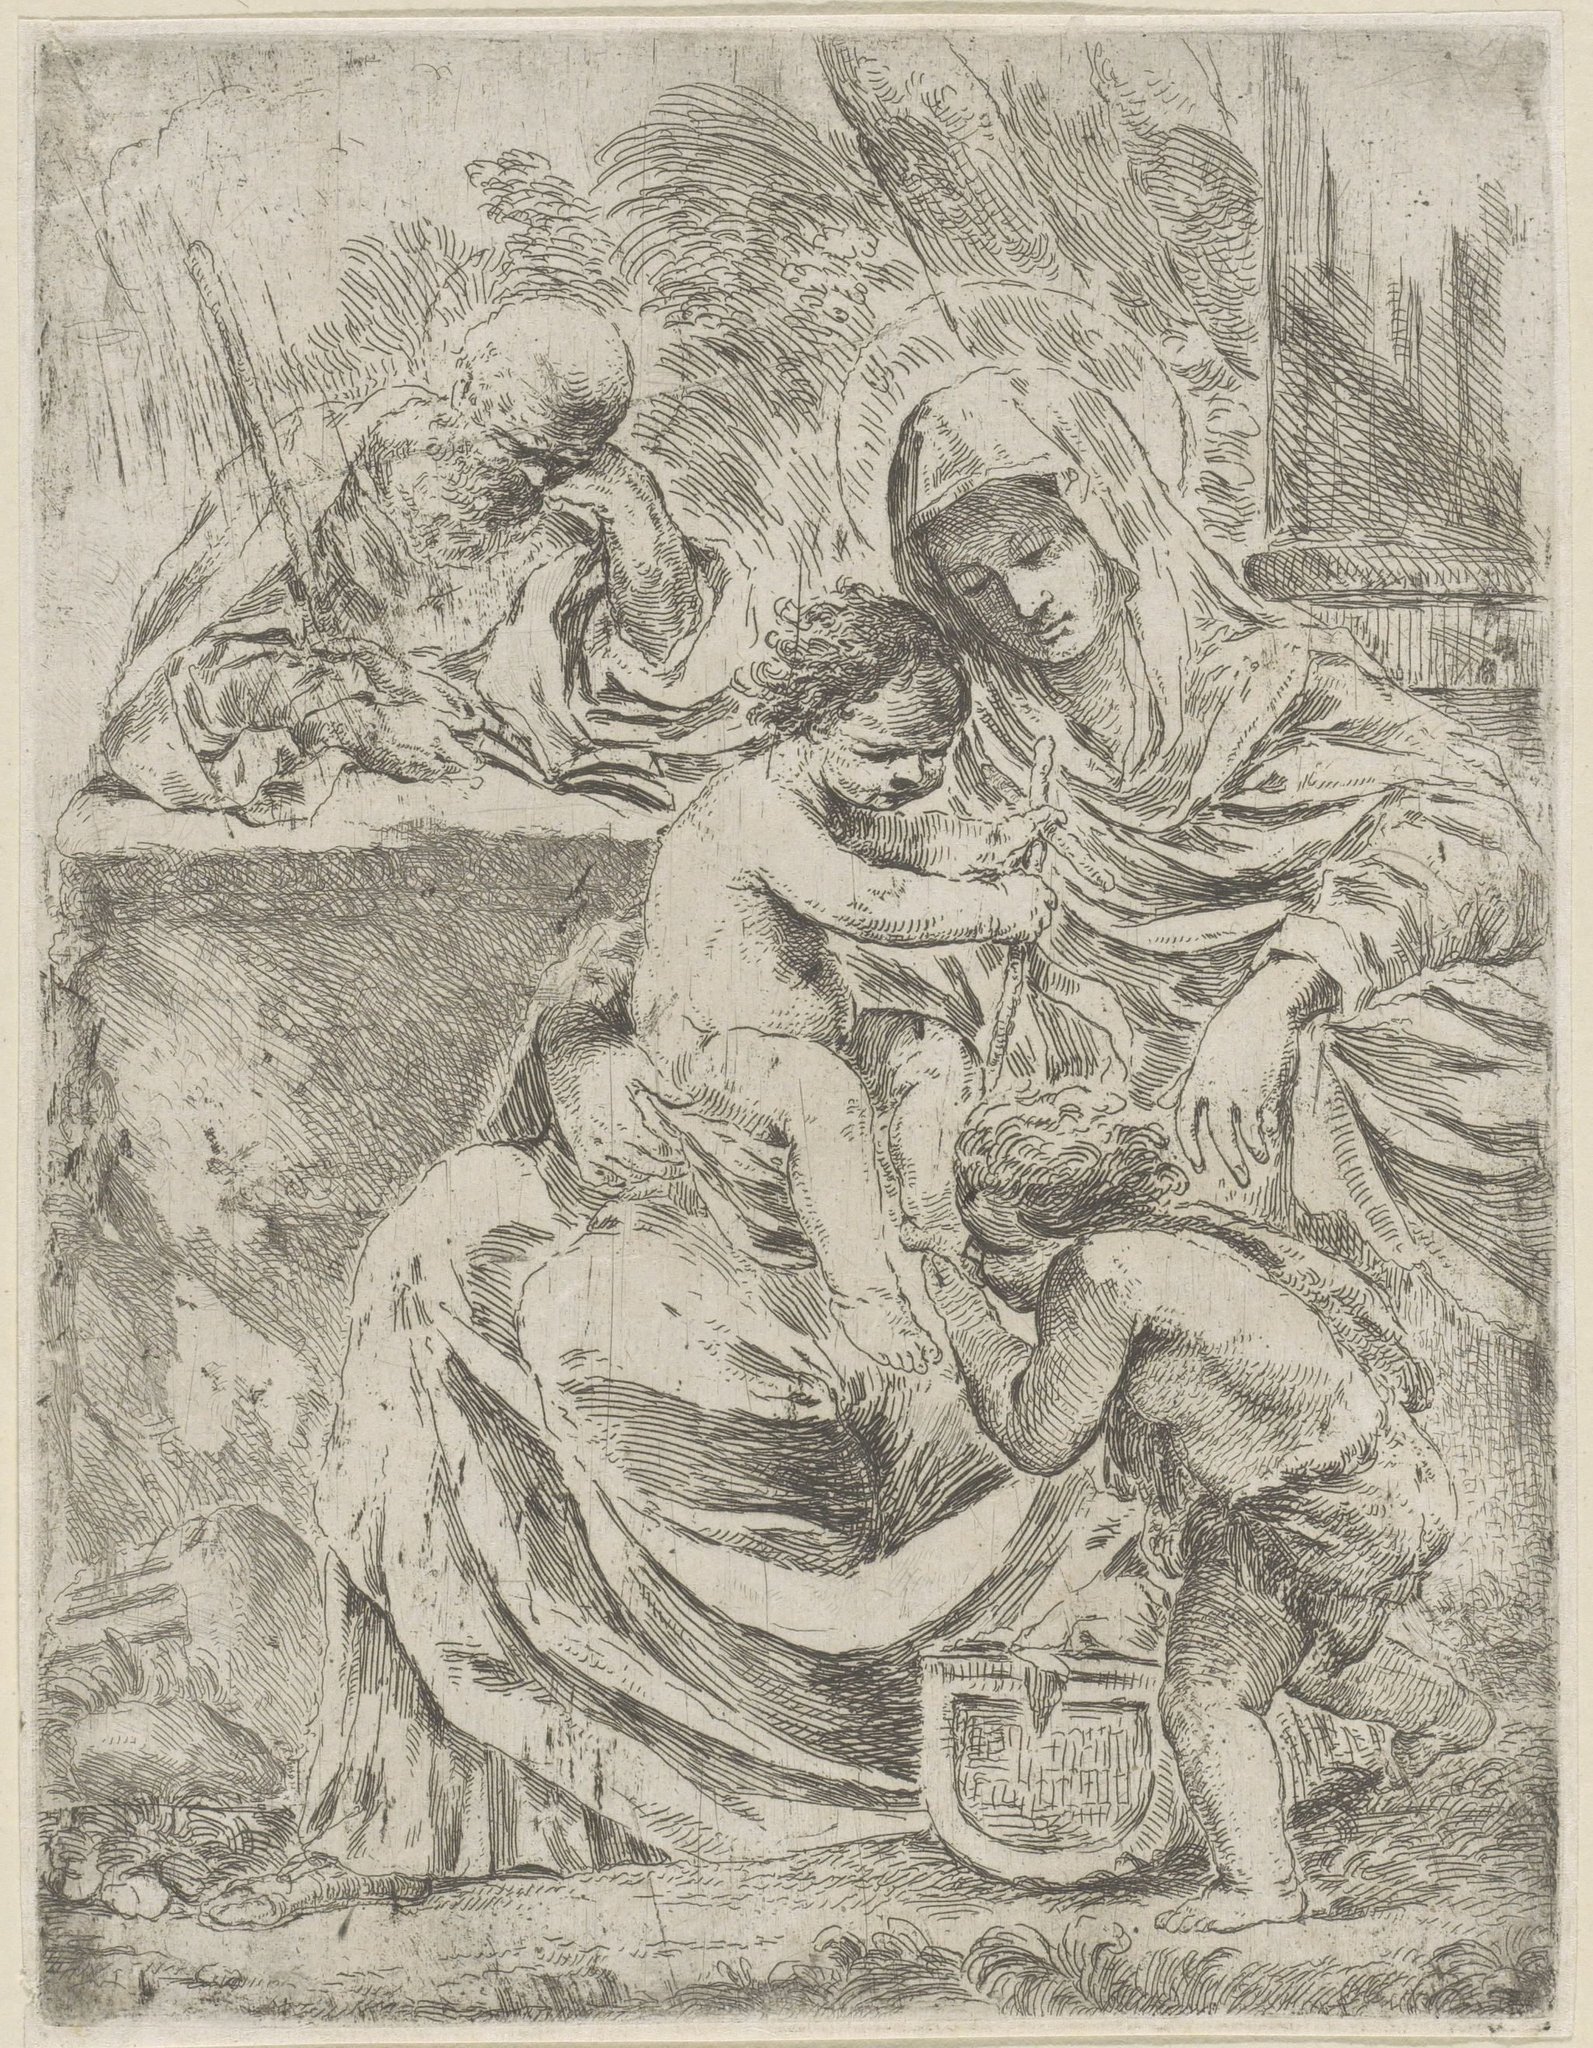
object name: print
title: Heilige Familie met Johannes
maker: francesco amato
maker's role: painter, print maker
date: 1585-1620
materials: paper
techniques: etching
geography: italy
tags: holy family with john the baptist (as child)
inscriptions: collector's mark: Lugt 240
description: Maria met het Christuskind op haar schoot. De jonge Johannes de Doper zoent de voet van Christus. Op de achtergrond leunt Jozef op een muur.